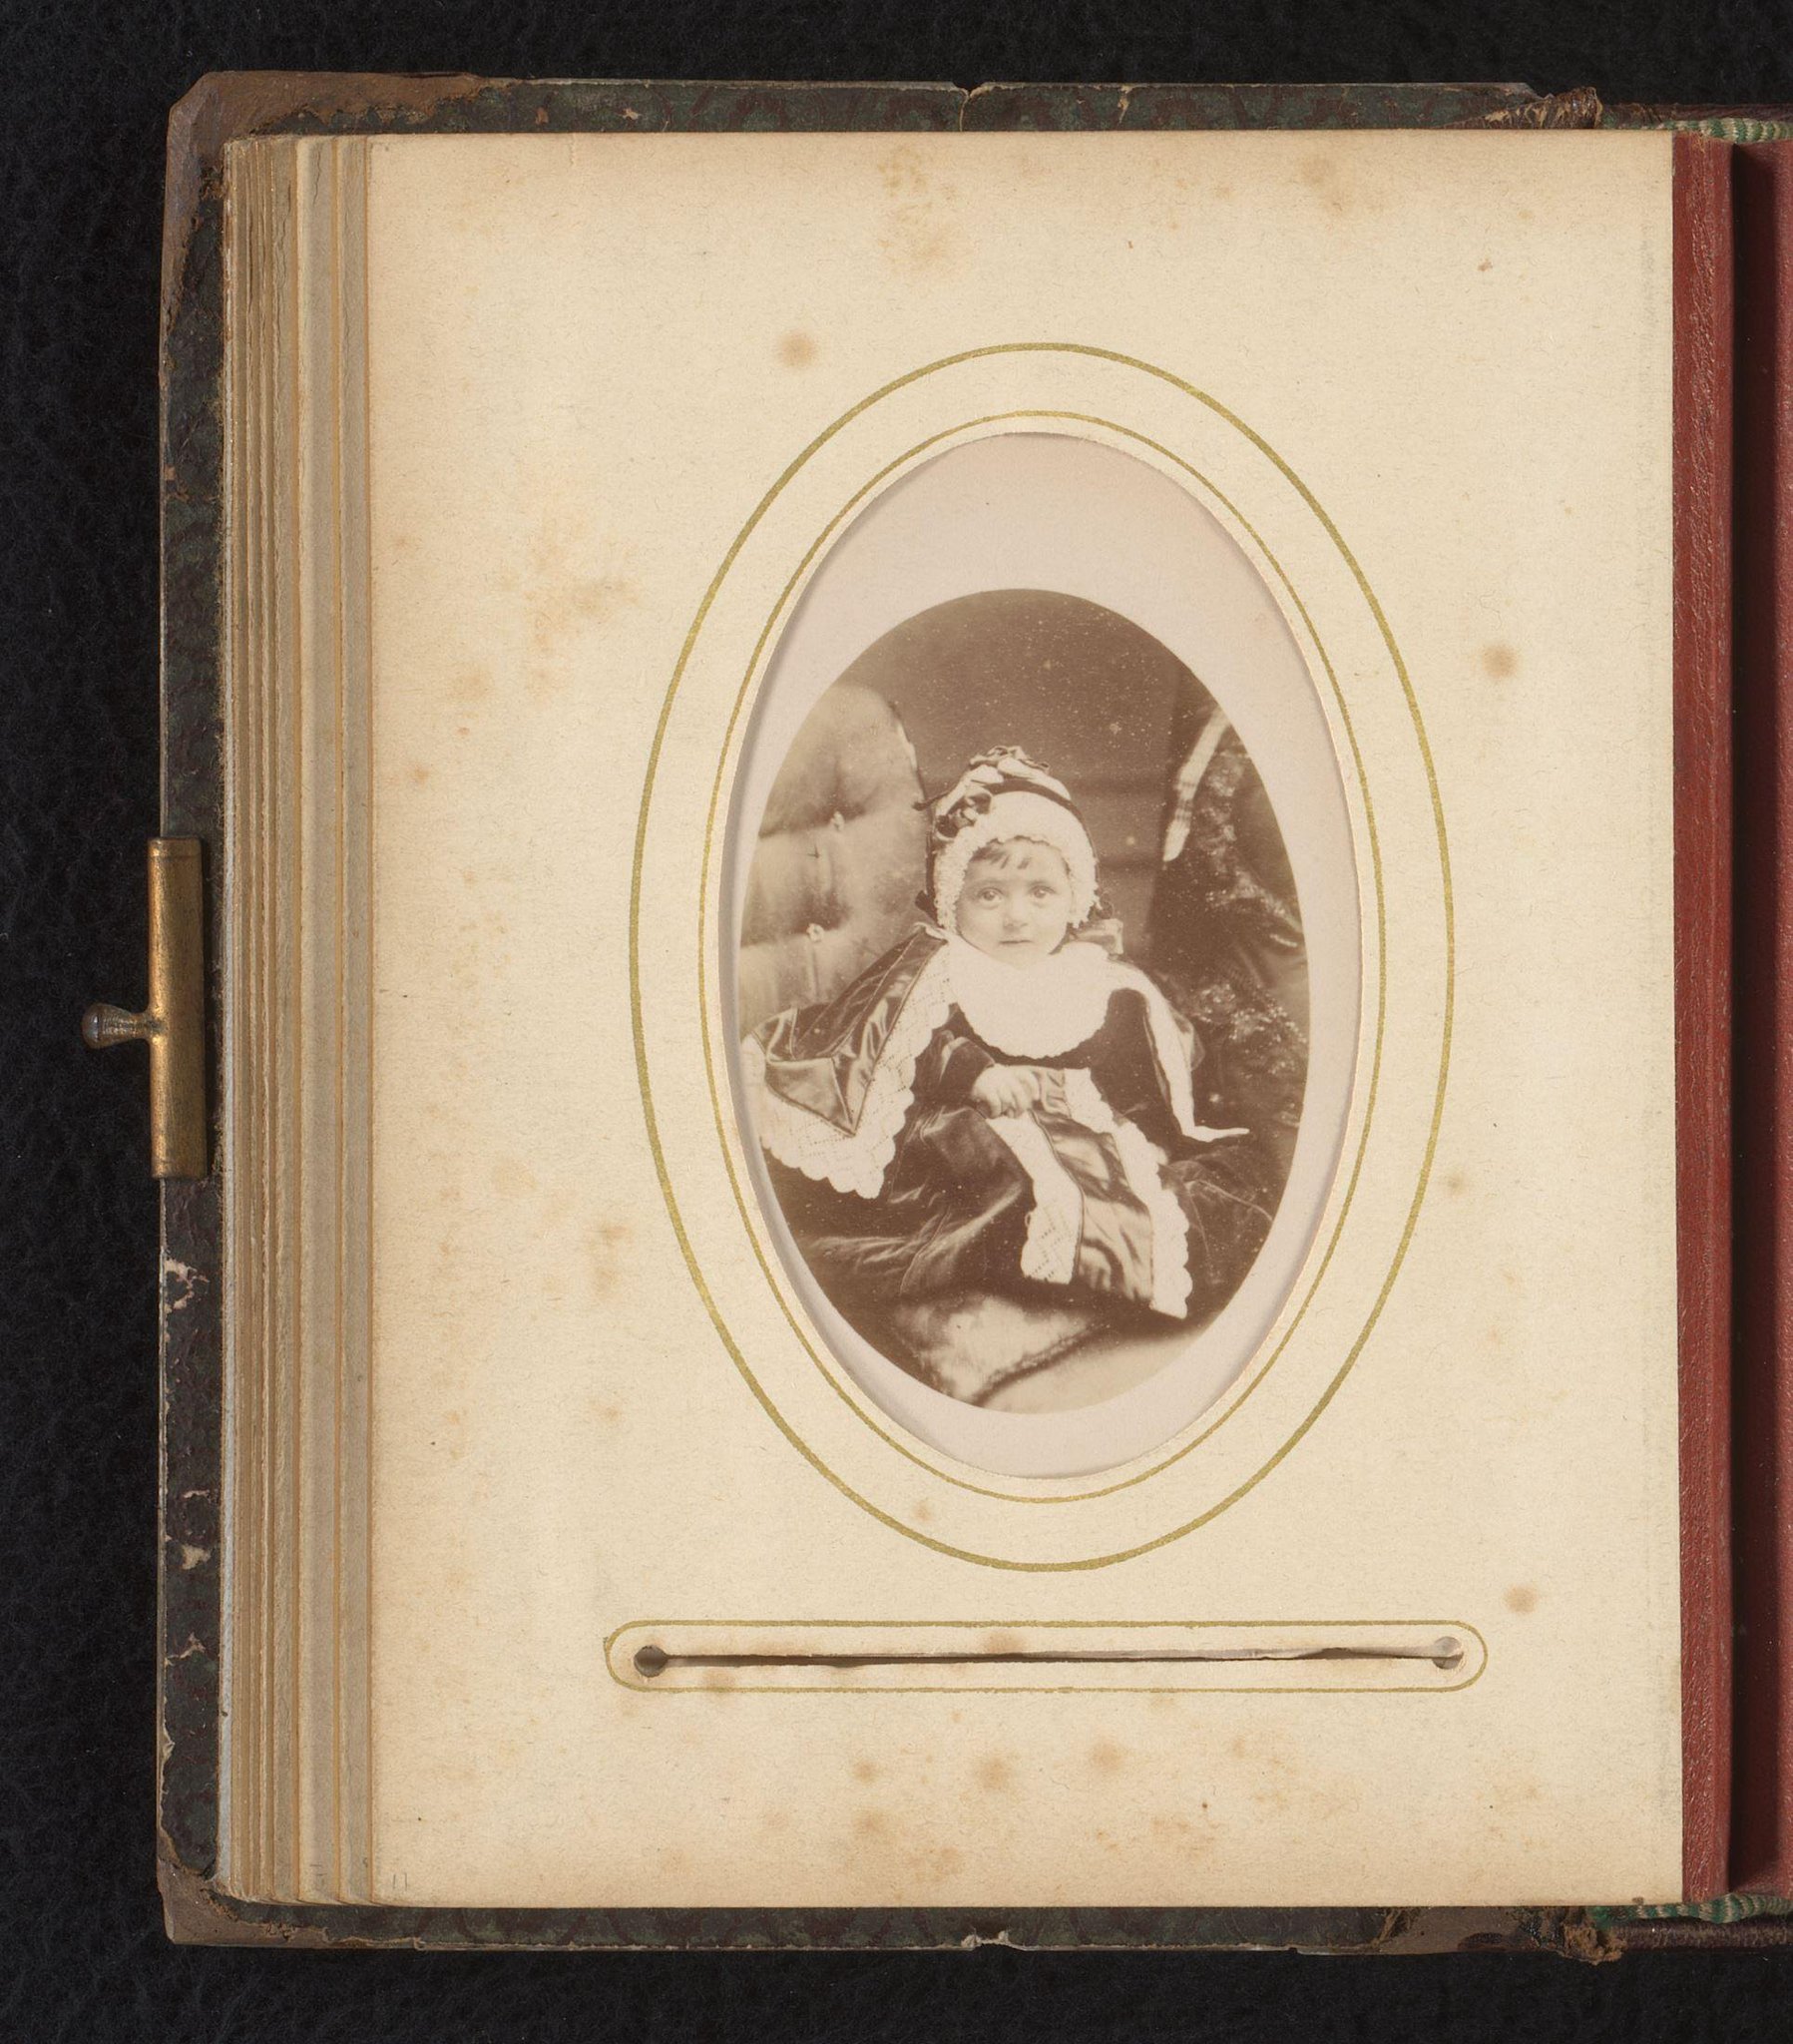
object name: album leaf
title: Portret van een peuter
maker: william flower maltby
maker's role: fotograaf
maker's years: 1844-1914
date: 1876-1881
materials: cardboard, photographic support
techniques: albumen print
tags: toddler, historical persons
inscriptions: inscription: ‘W. Flower Maltby/ Photographer and miniature painter/ 176, Upper Street/ Islington (...)’